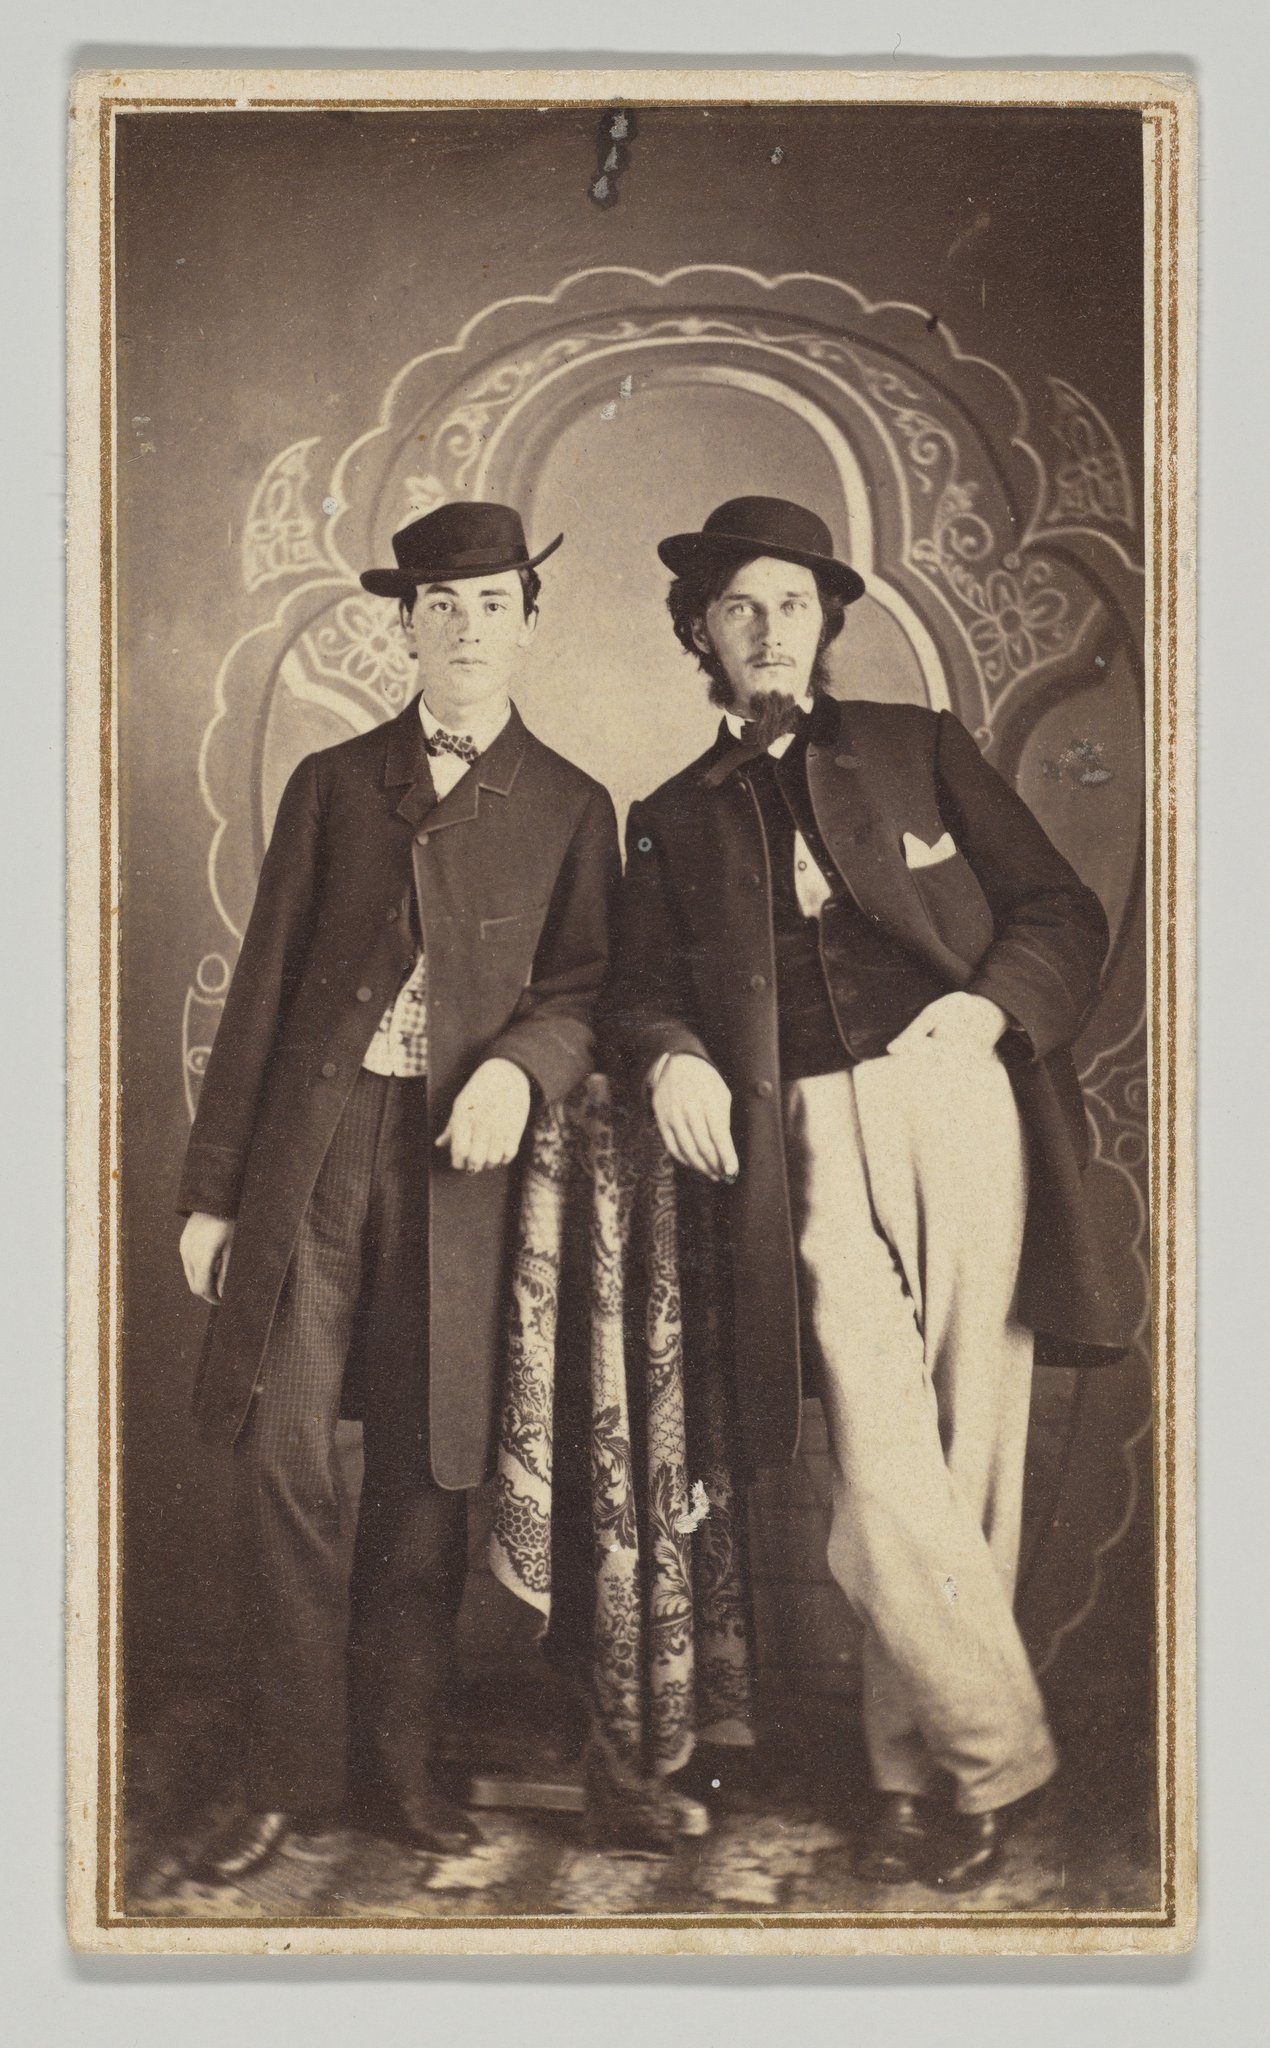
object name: photograph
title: [Two Men Standing in Front of Backdrop]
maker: d. a. douglass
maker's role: photography studio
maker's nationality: american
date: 1860-1869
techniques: albumen silver print